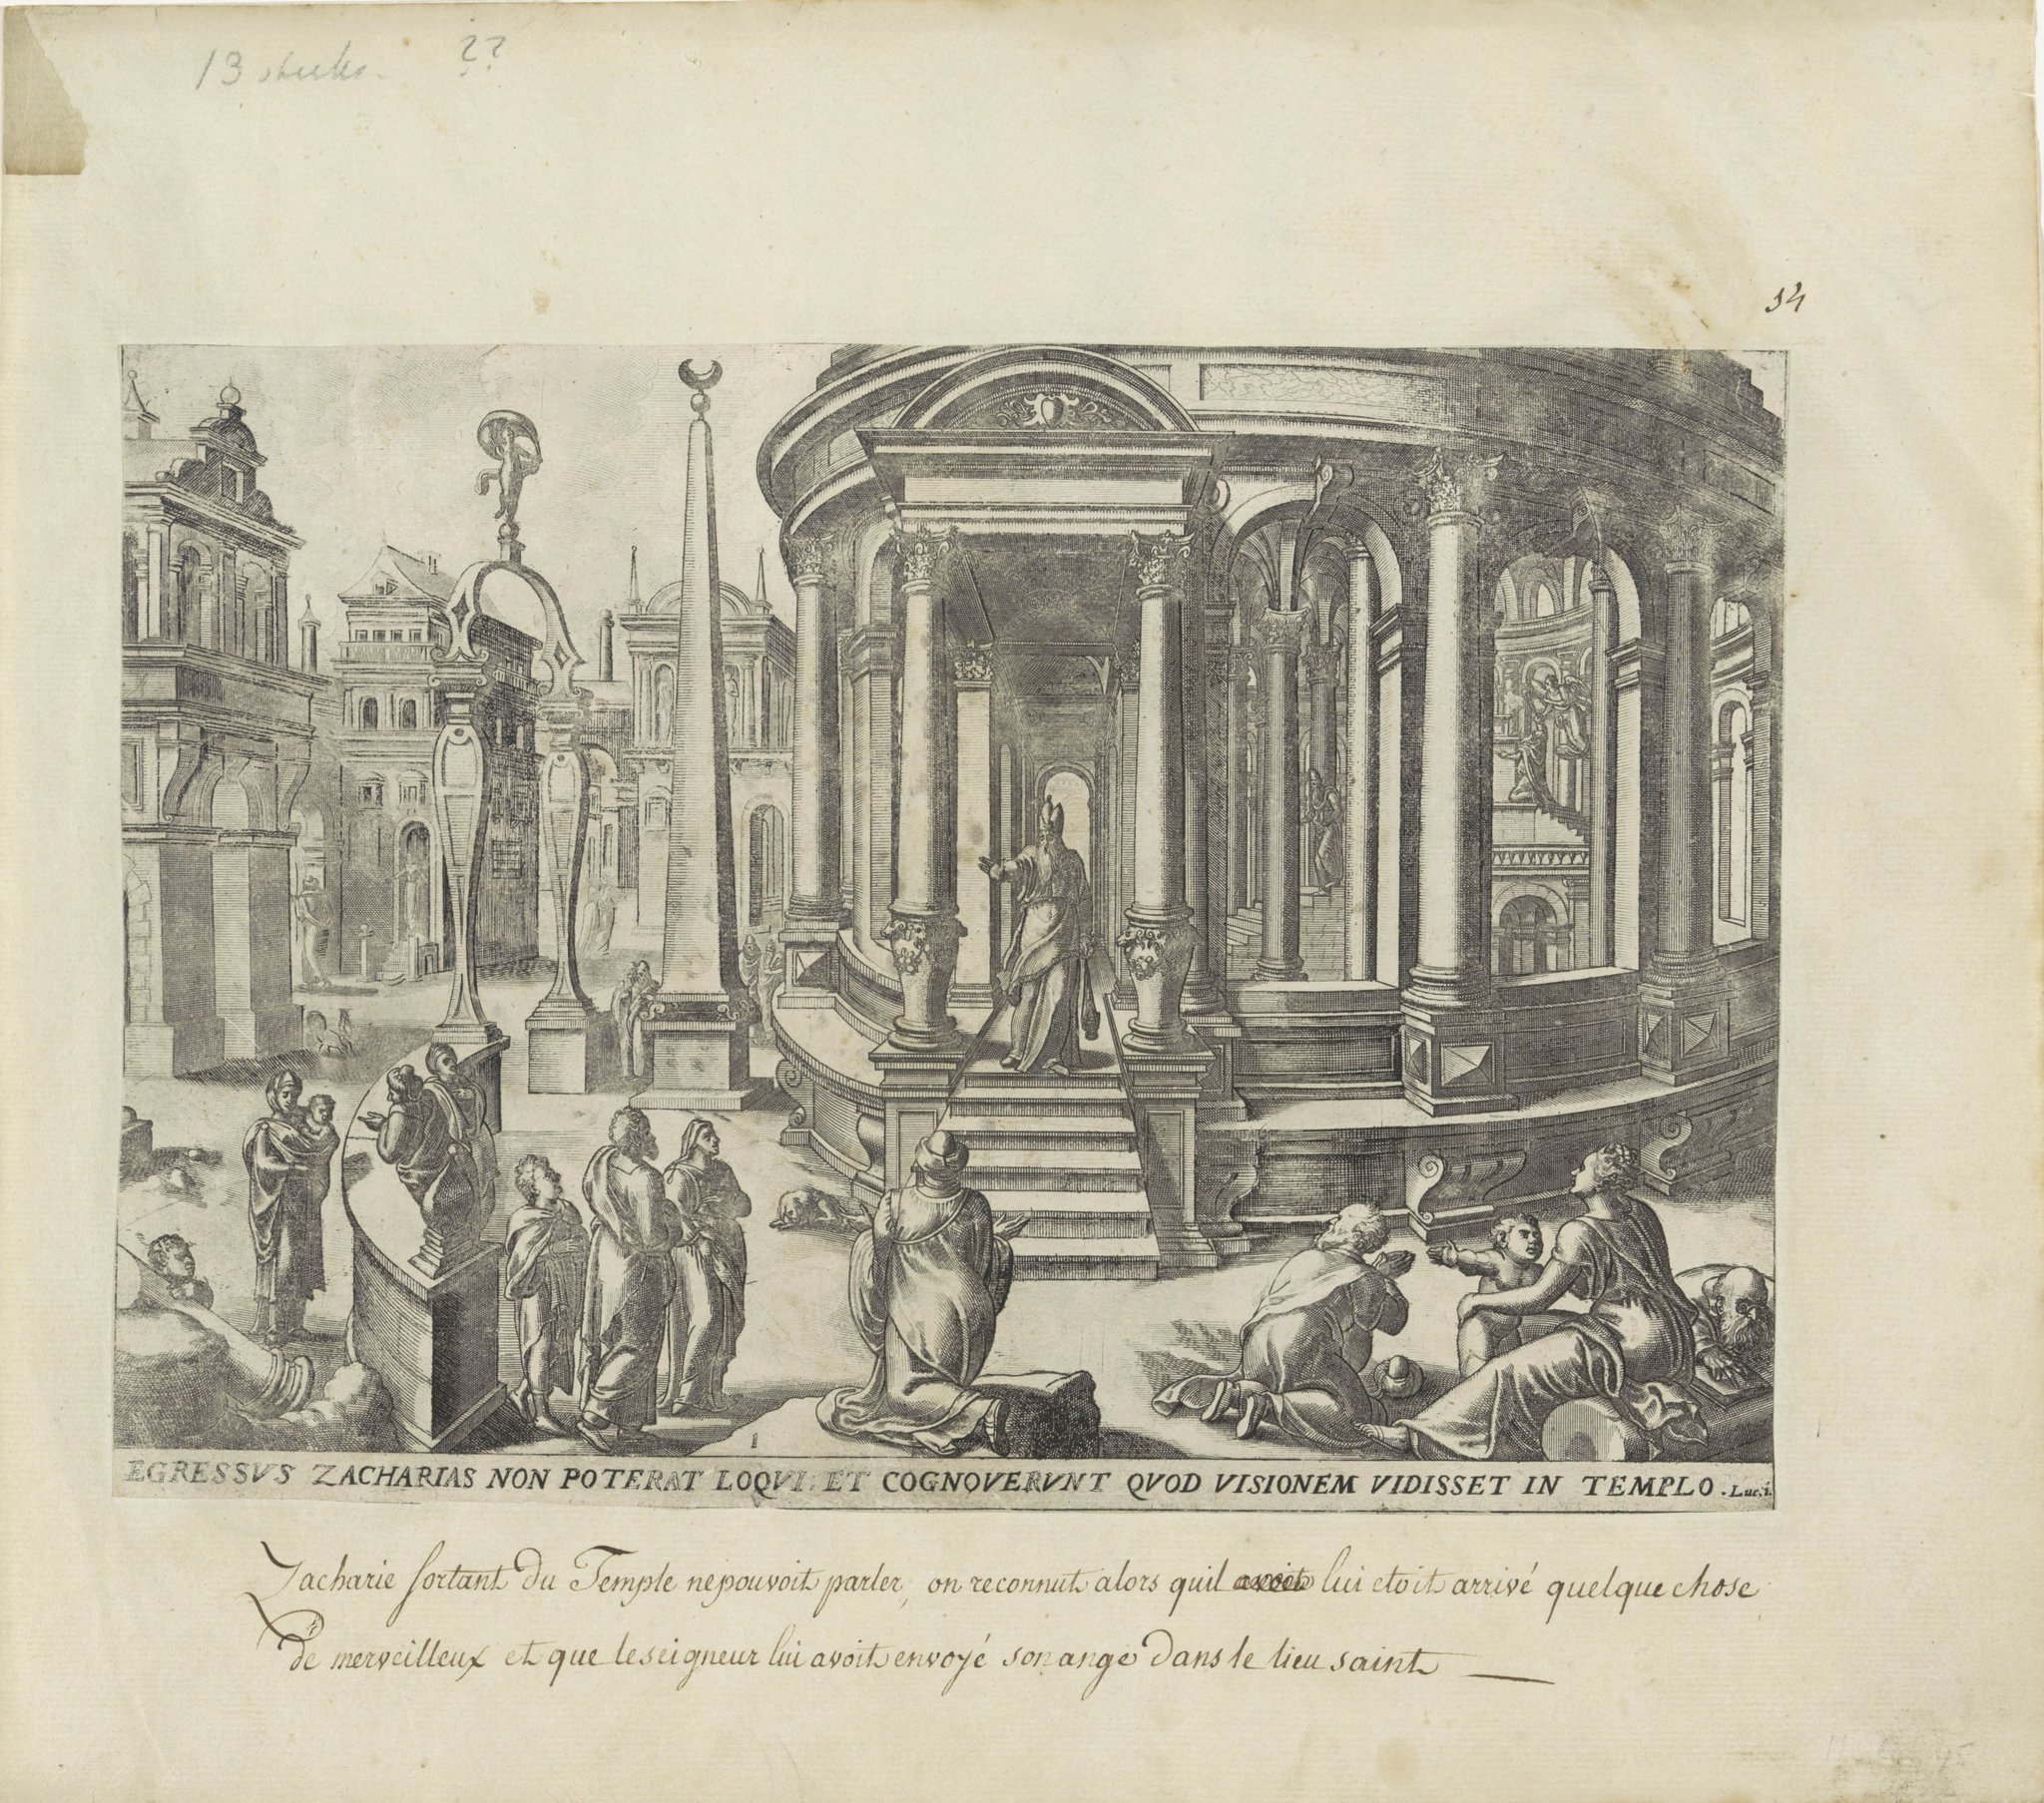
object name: print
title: Zacharias op de treden van de tempel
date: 1585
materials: paper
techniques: engraving, etching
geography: antwerp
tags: zacharias speechless before the people, being silent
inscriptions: inscription: ‘Zacharie fortant du Temple ne pouvoit parler, on reconnut alors quil lui etoit arrivé quelque chose de merveilleux et que le seigneur lui avoit envoyé son ange dans le lieu saint’, number: ‘14’, collector's mark: Lugt 2228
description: In de tempel verschijnt de engel Gabriël aan de hogepriester Zacharias, die hem zegt dat hij een zoon zal krijgen. Omdat Zacharias dit niet gelooft wordt hem zijn spraakvermogen ontnomen. Als hij verschijnt op de trappen van de tempel om de menigte toe te spreken kan hij niets meer zeggen. Onder de voorstelling een verwijzing in het Latijn naar de Bijbeltekst in Luc. 1.